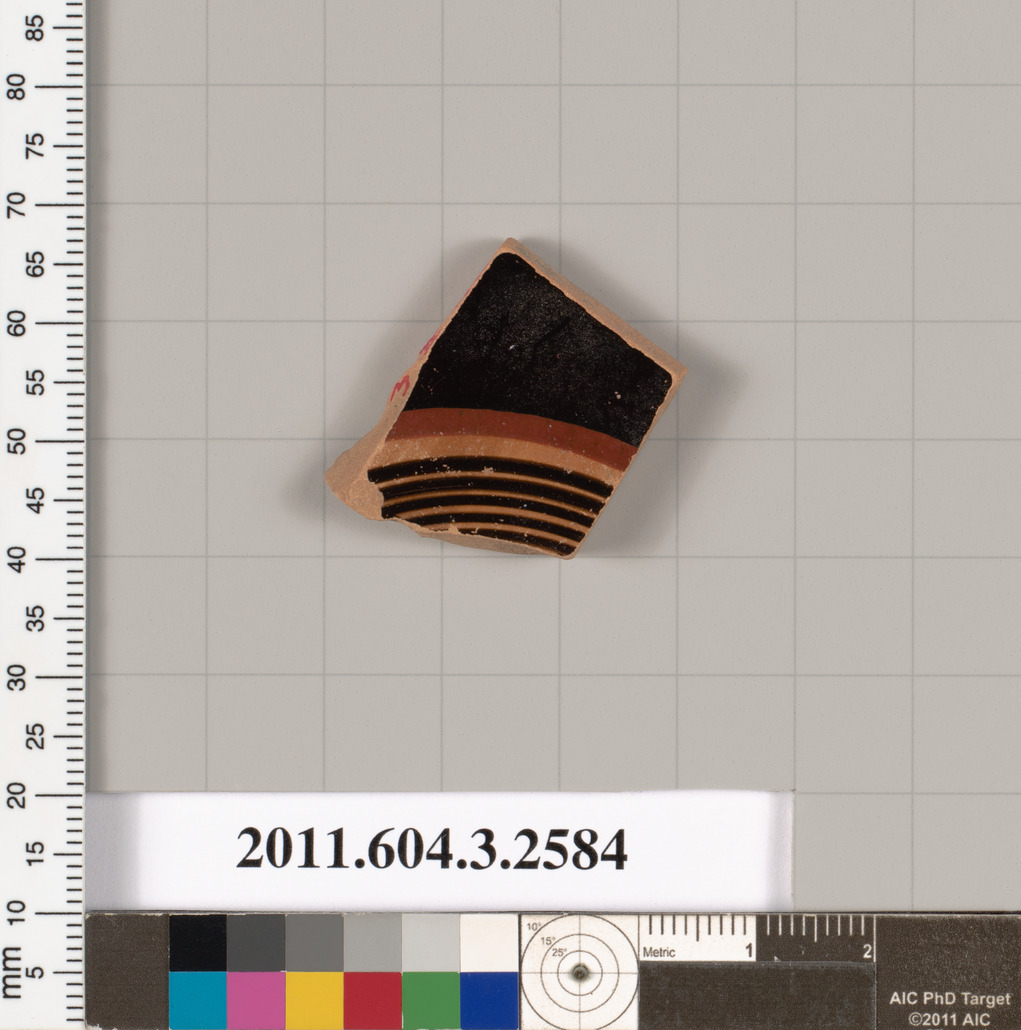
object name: kylix fragment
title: Terracotta fragment of a Little Master cup (drinking cup)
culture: greek, attic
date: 575-551 BCE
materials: terracotta